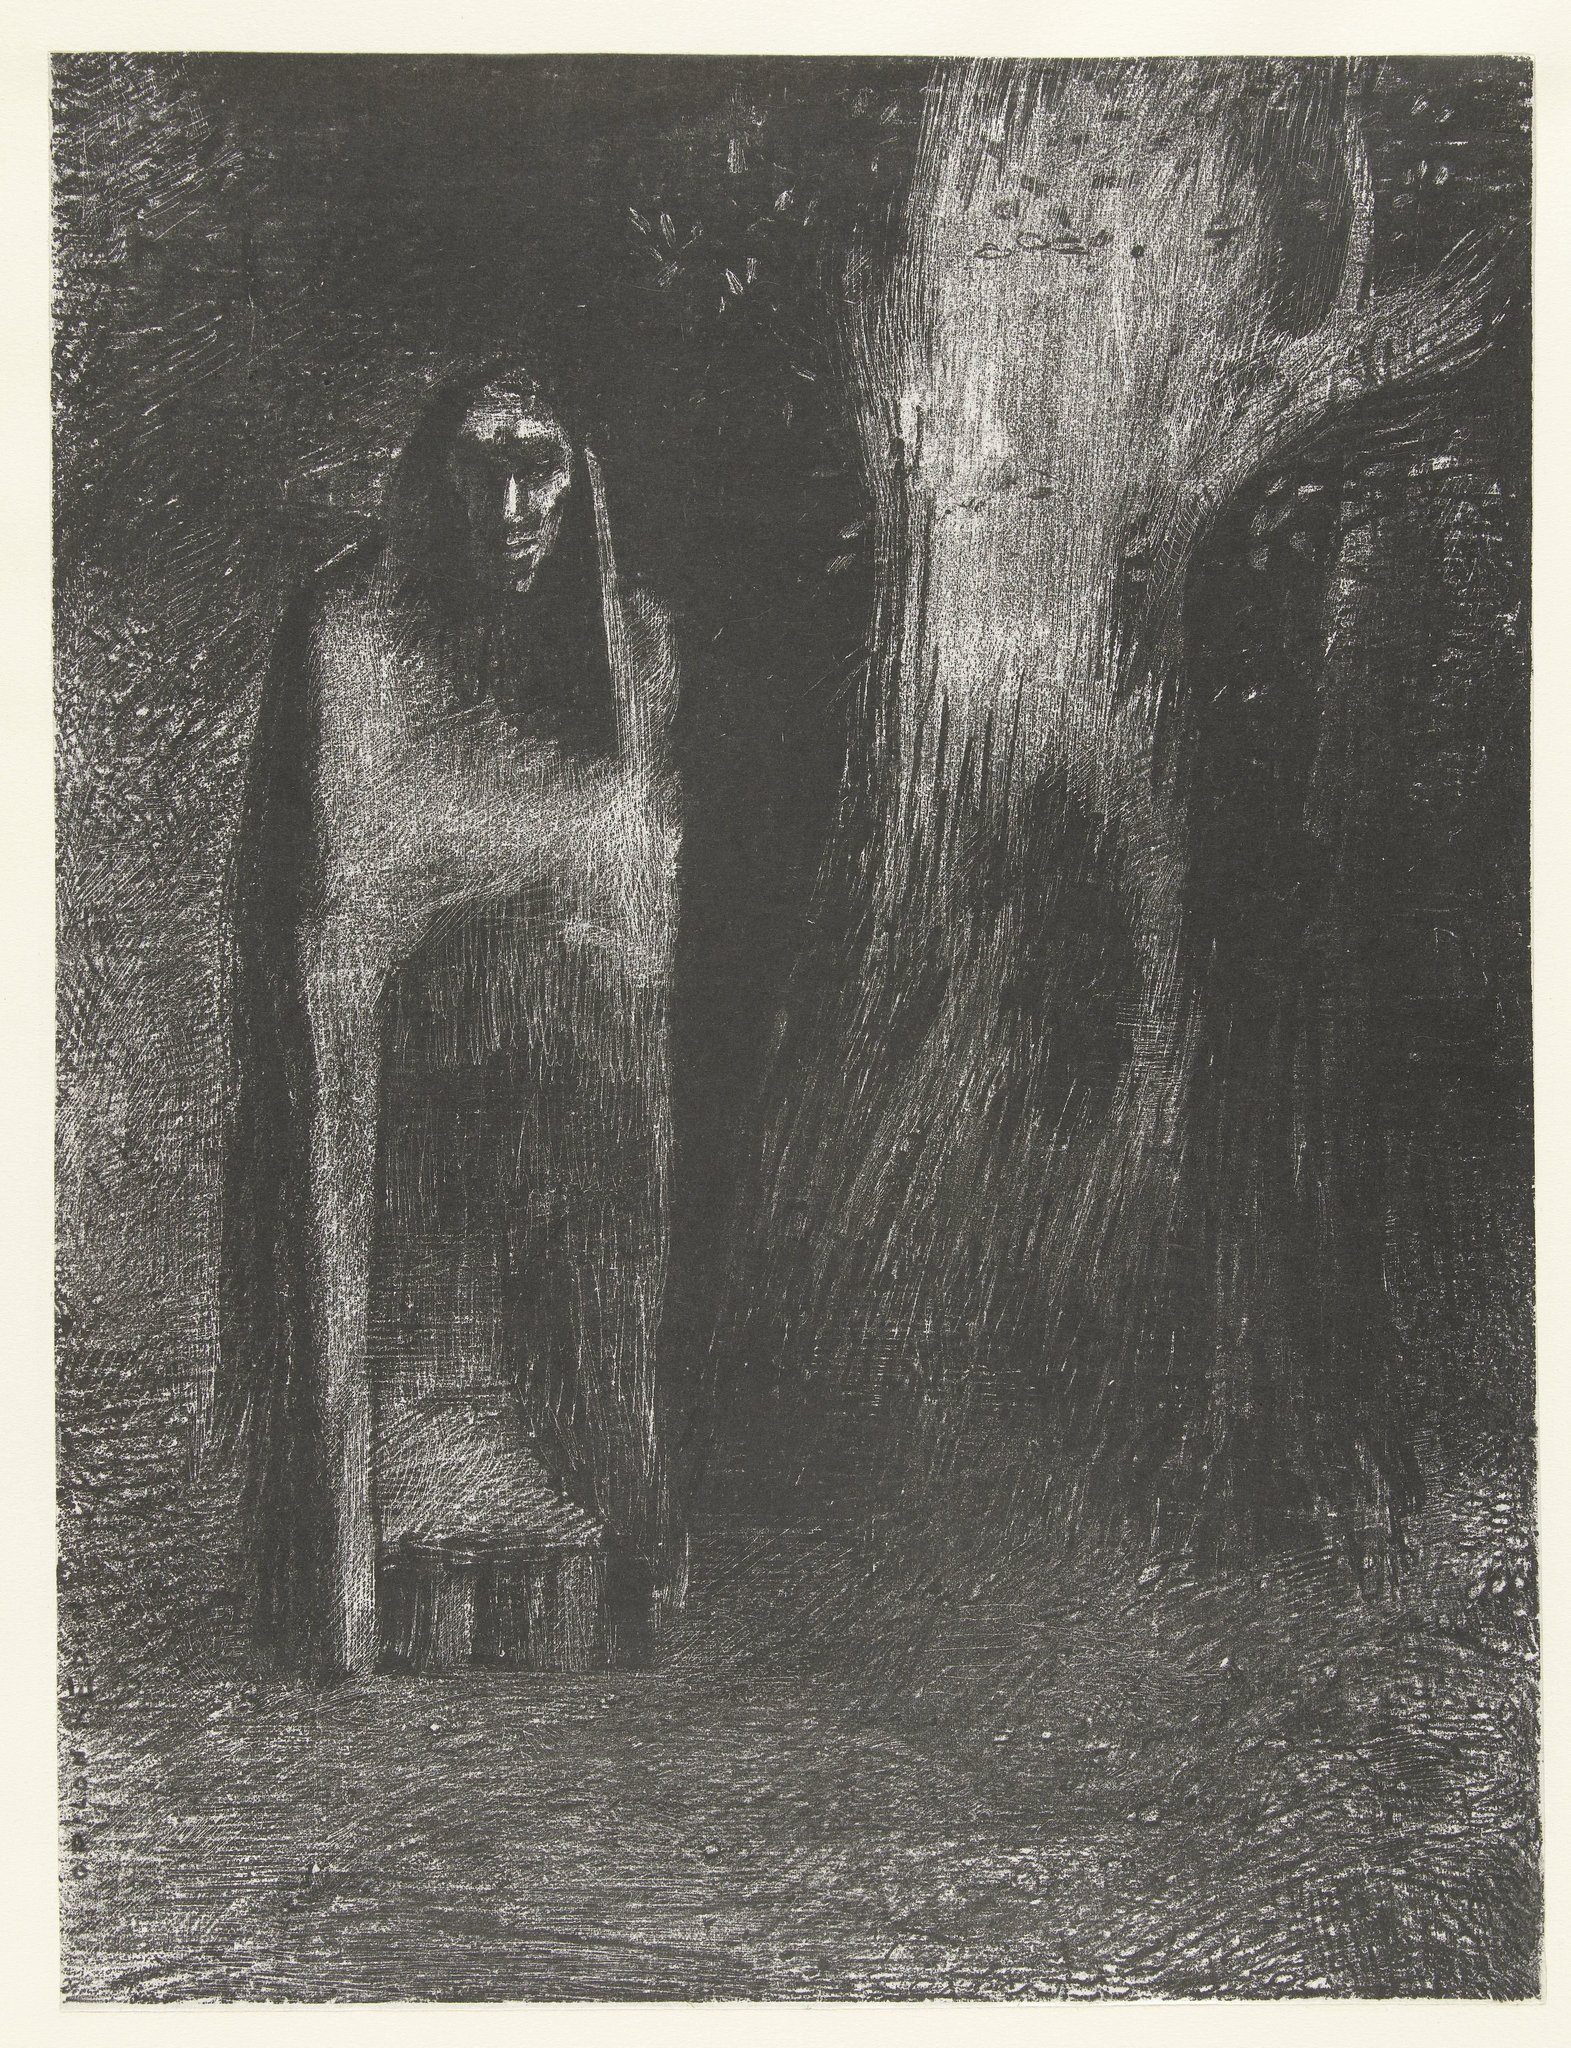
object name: print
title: L'homme fut solitaire dans un paysage de nuit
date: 1886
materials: paper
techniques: lithograph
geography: paris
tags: adult man (+ standing), night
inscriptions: collector's mark: Lugt 2228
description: Een man in de nacht, van voren gezien, staand naast een boom. Prent uit een serie van zes, gemaakt voor een album.